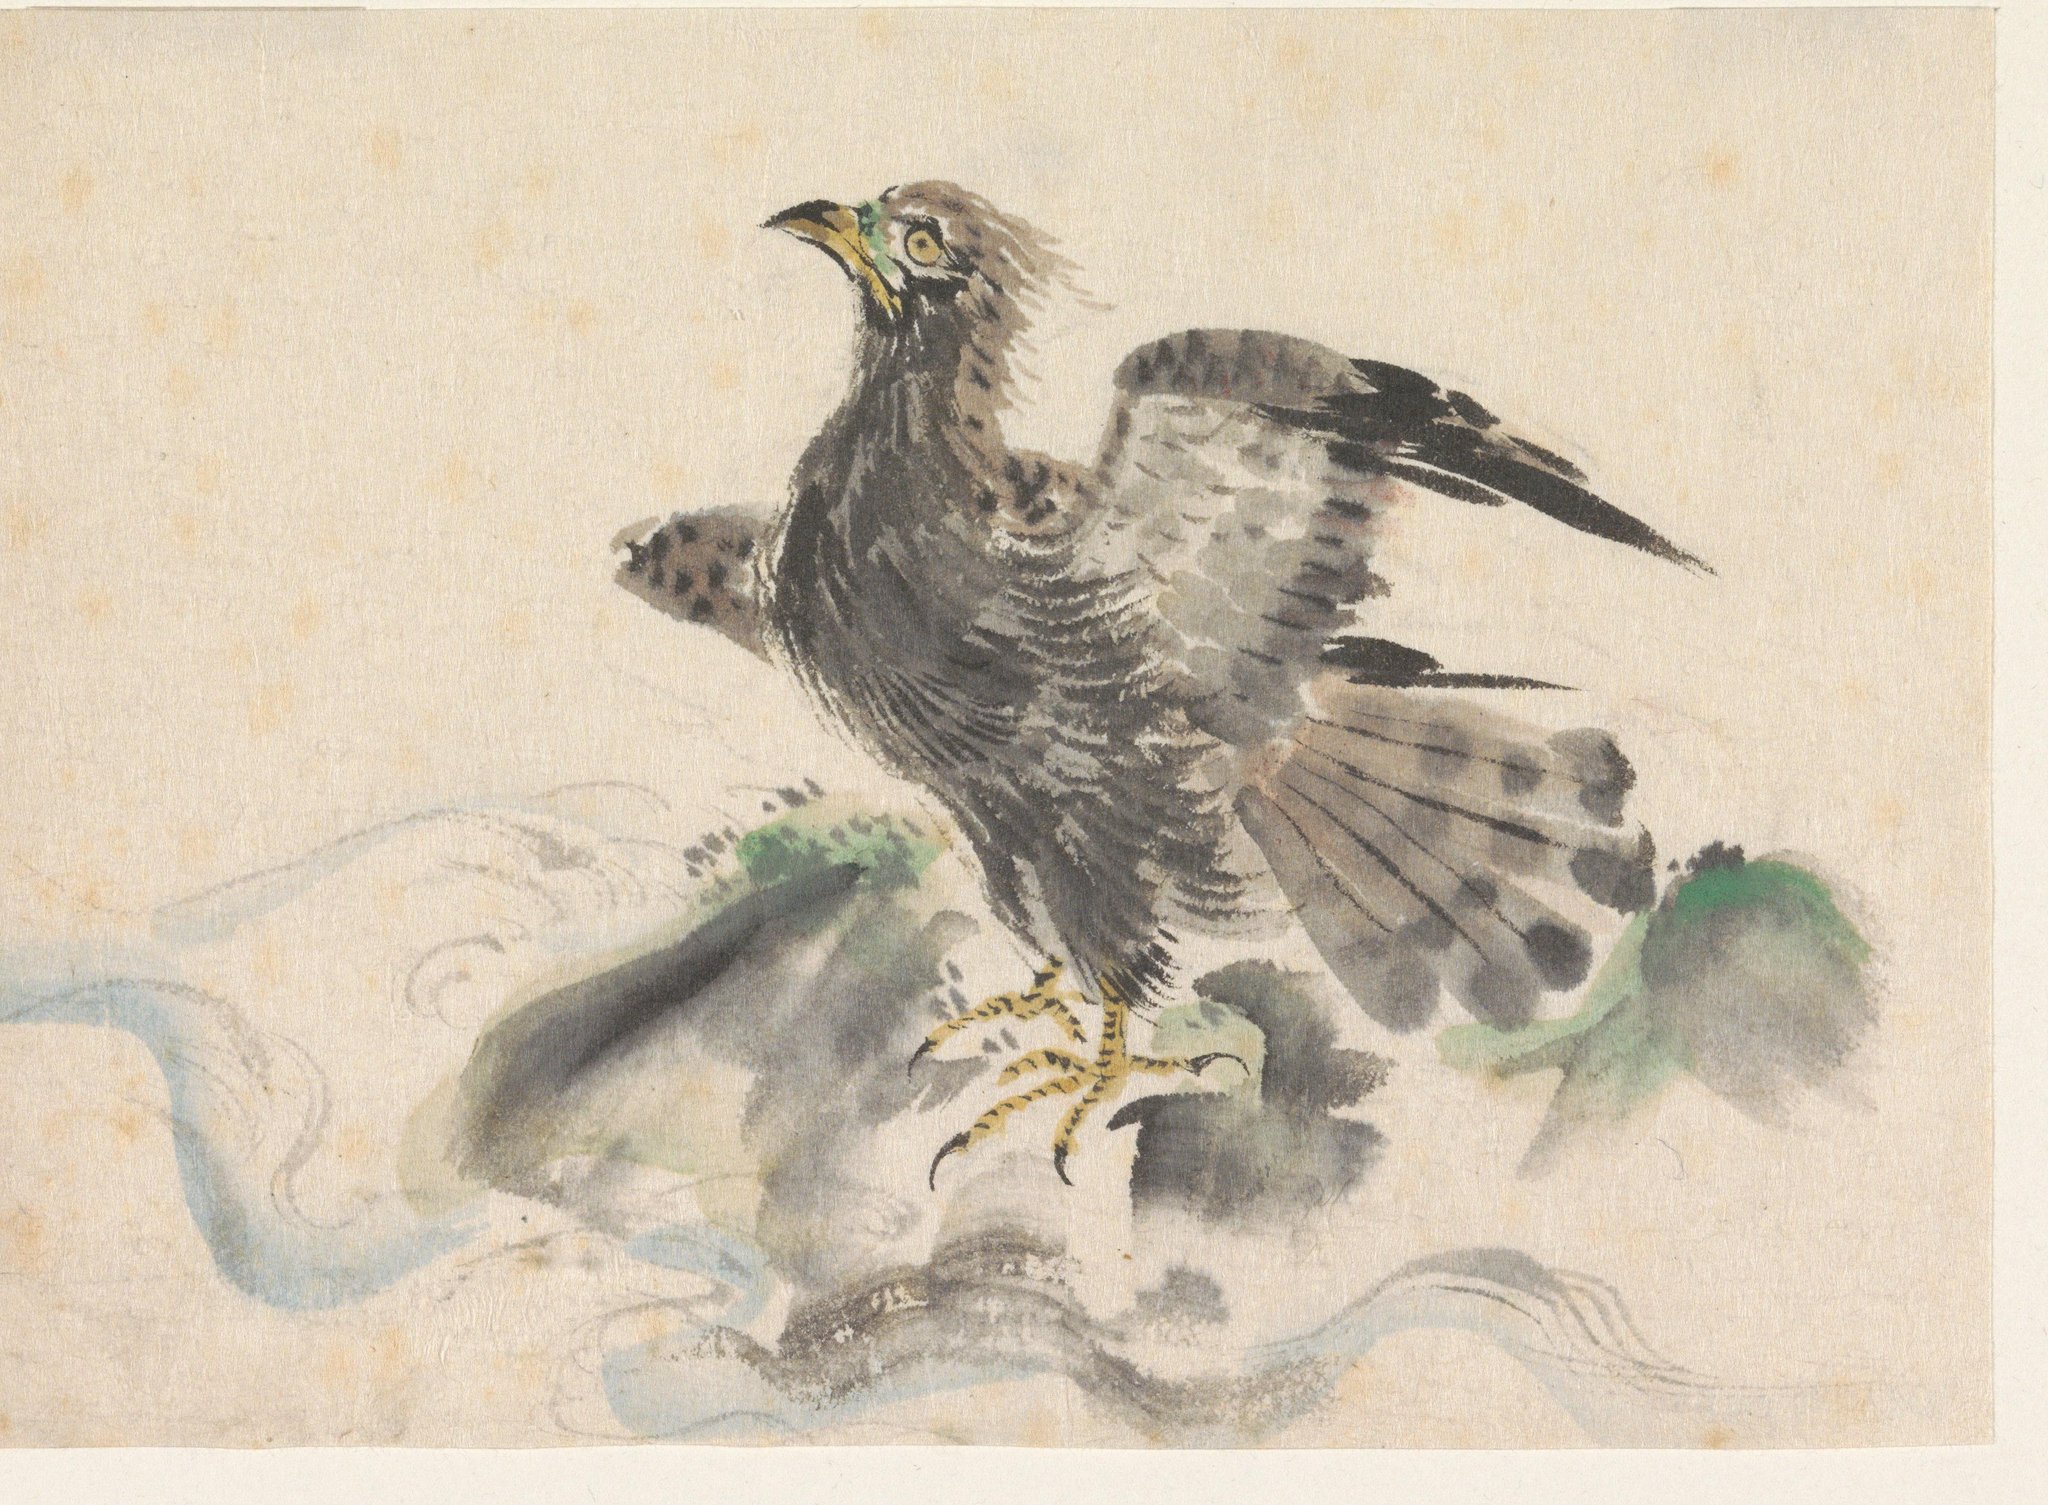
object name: watercolor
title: Roofvogel op rots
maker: utagawa kuniyoshi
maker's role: draughtsman, print maker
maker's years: 1798-1861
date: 1808-1861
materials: paper, watercolor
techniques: brush